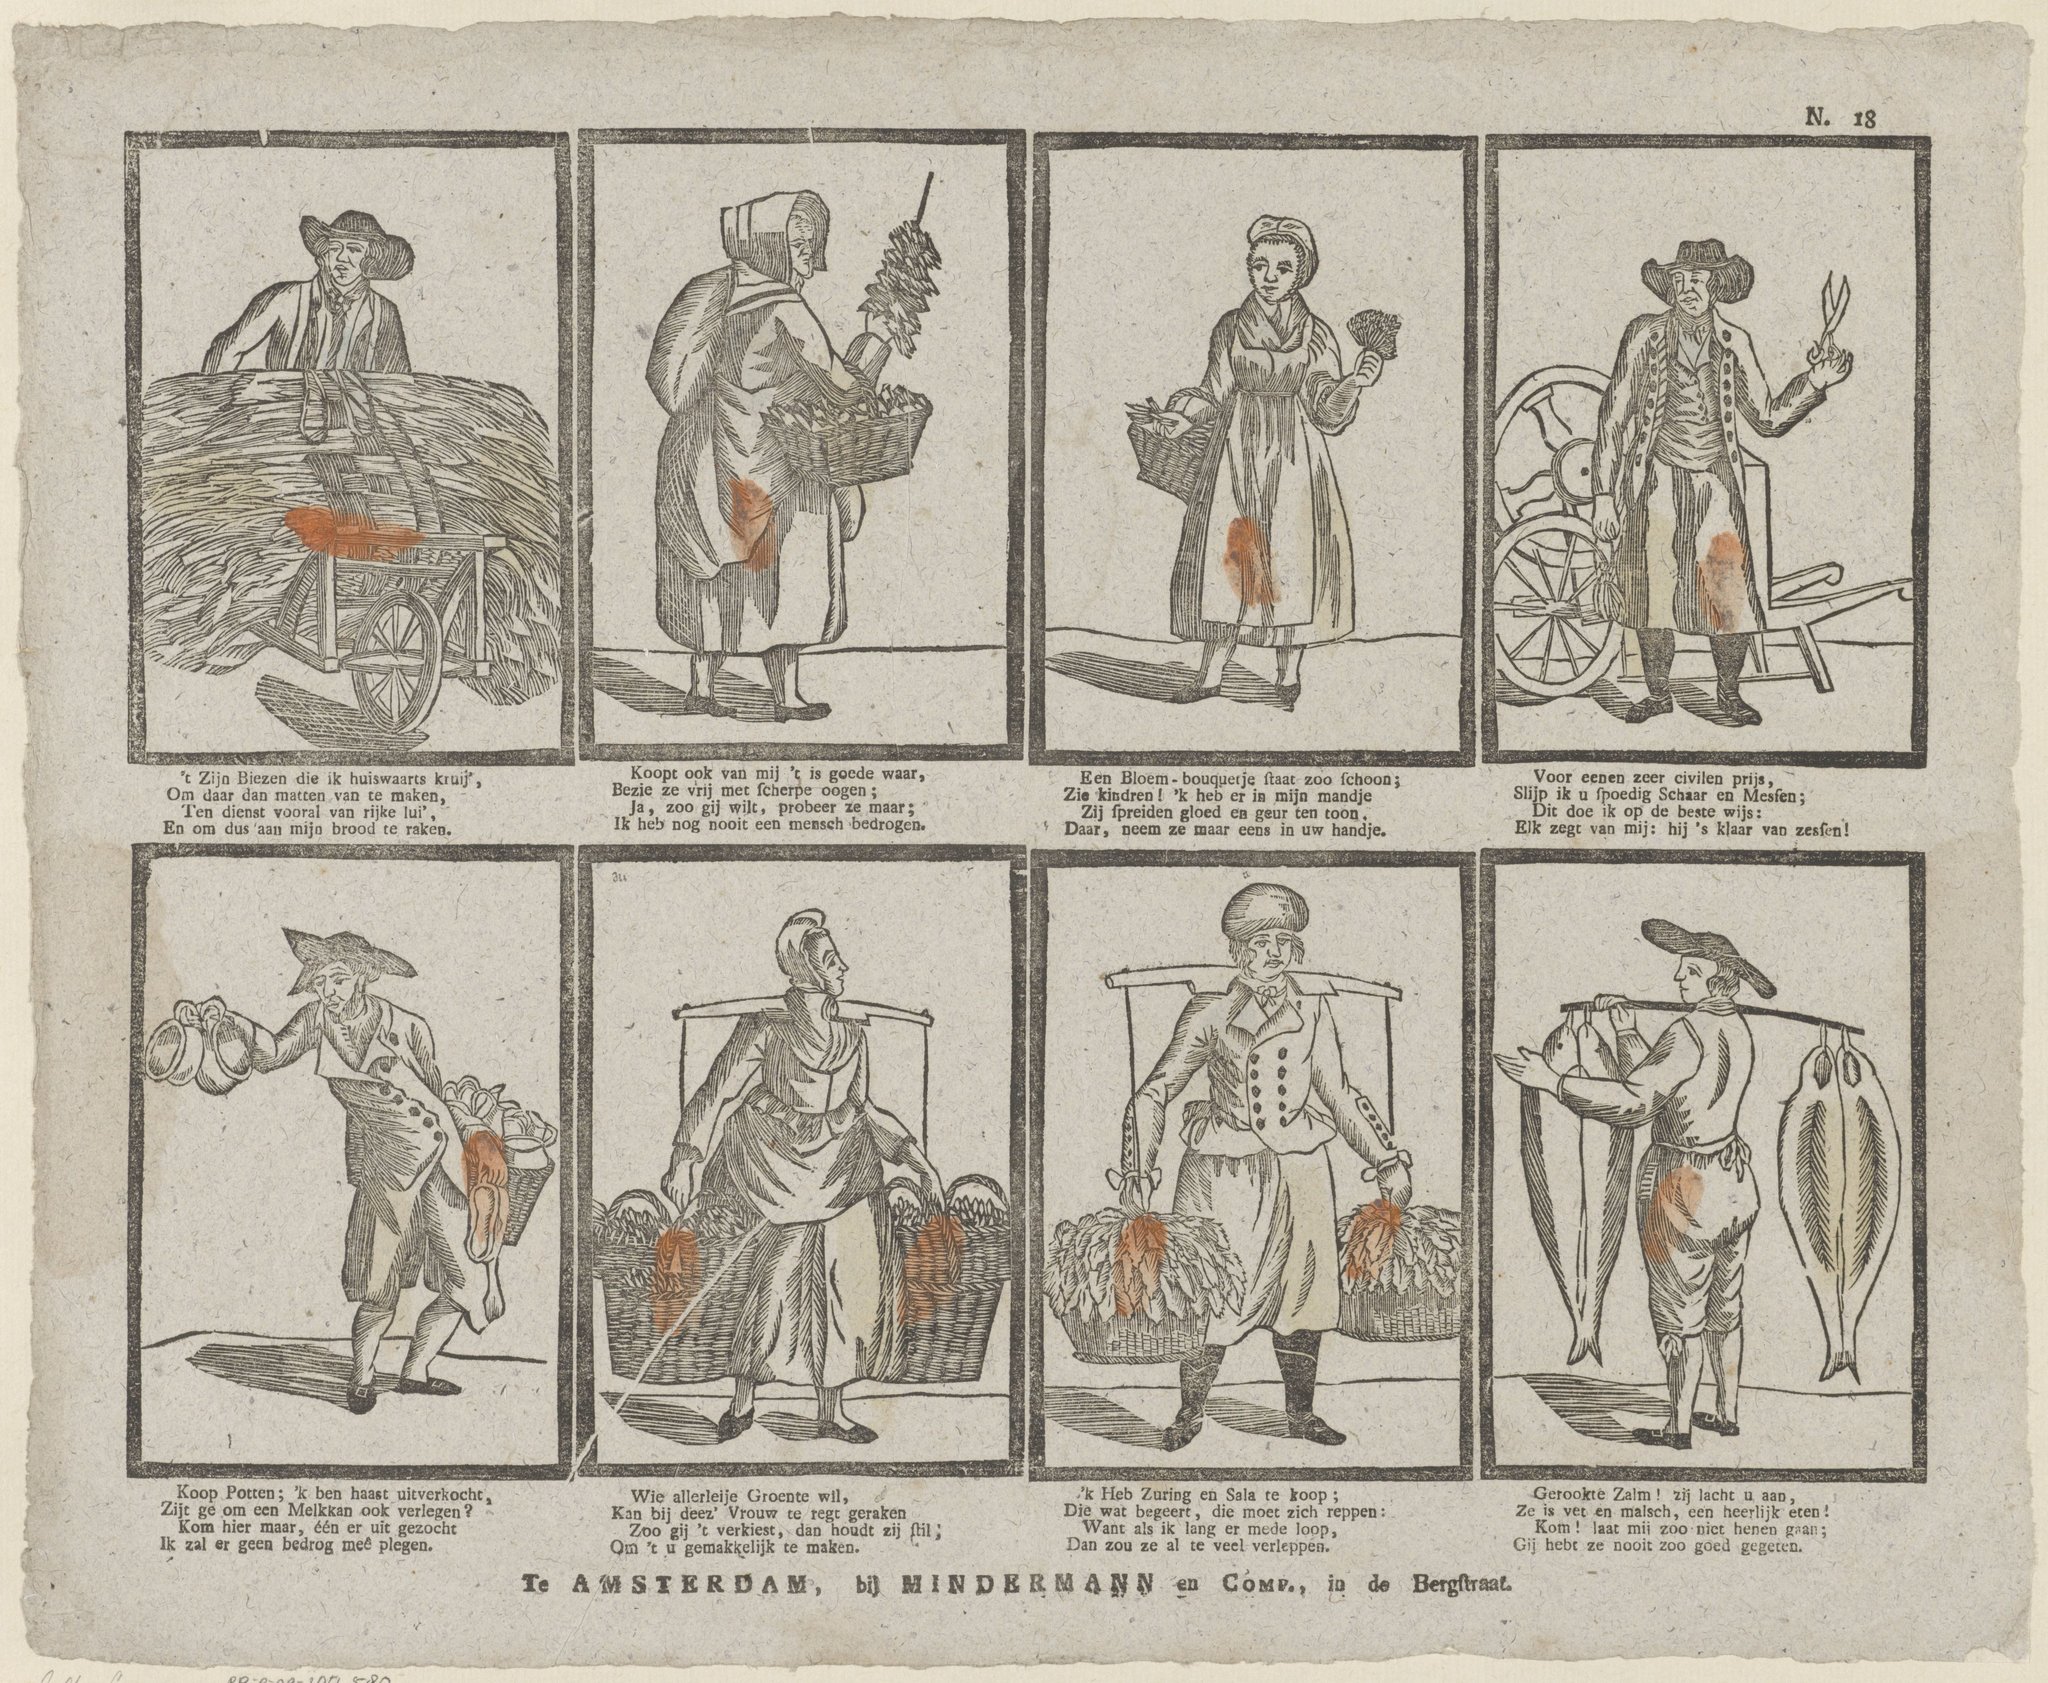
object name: popular print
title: Straatverkopers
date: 1822-1849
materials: paper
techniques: colour, letterpress printing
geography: netherlands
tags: street-trader, merchant, salesman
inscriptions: collector's mark: Lugt 2760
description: Blad met 8 voorstellingen van straatverkopers, zoals een mattenverkoper, een pottenverkoper en een zalmverkoper. Onder elke afbeelding een vierregelig vers. Genummerd rechtsboven: N. 18.